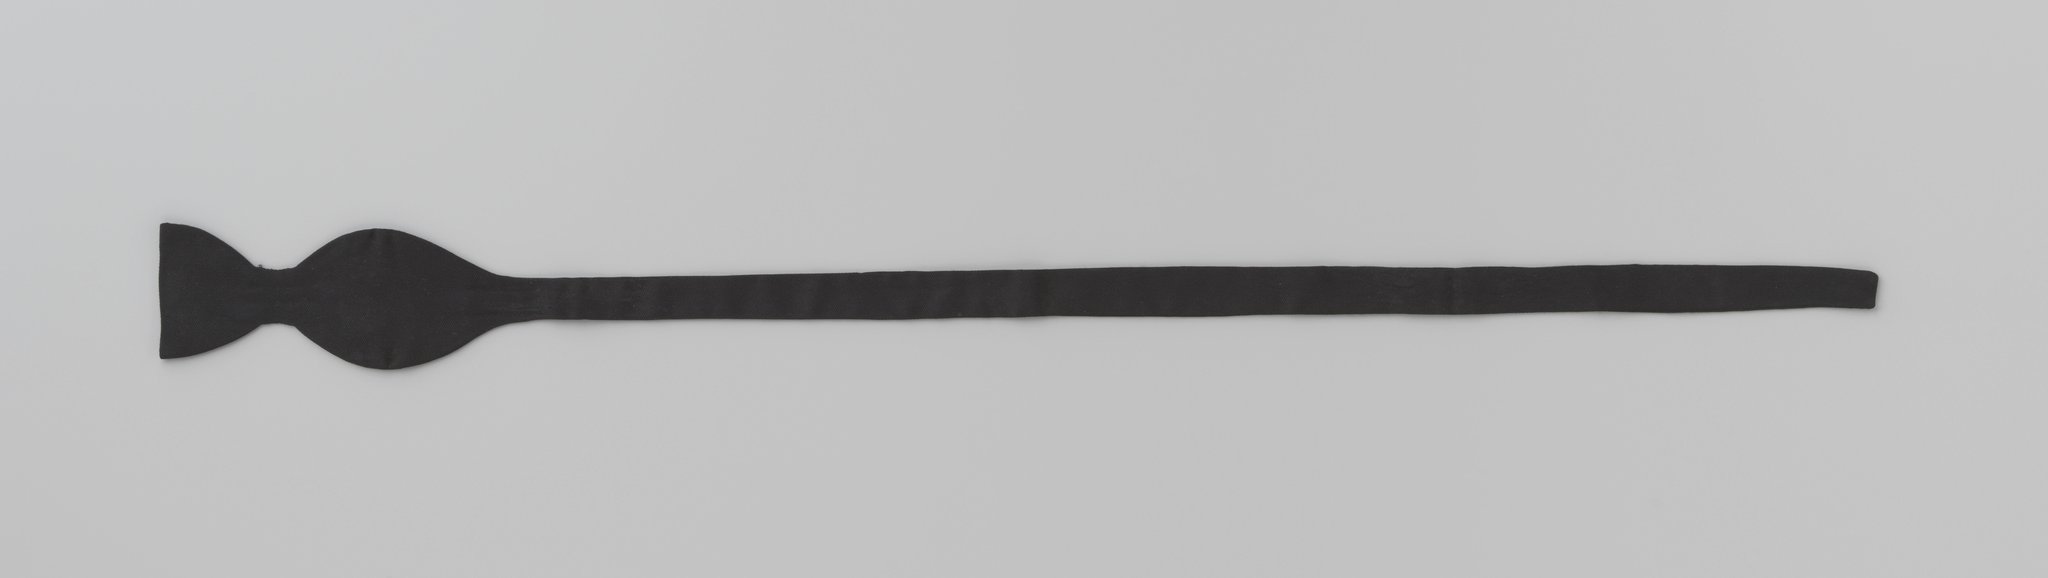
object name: bow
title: Zwarte strik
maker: Anonymous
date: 1920-1980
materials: textile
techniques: weave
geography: europe